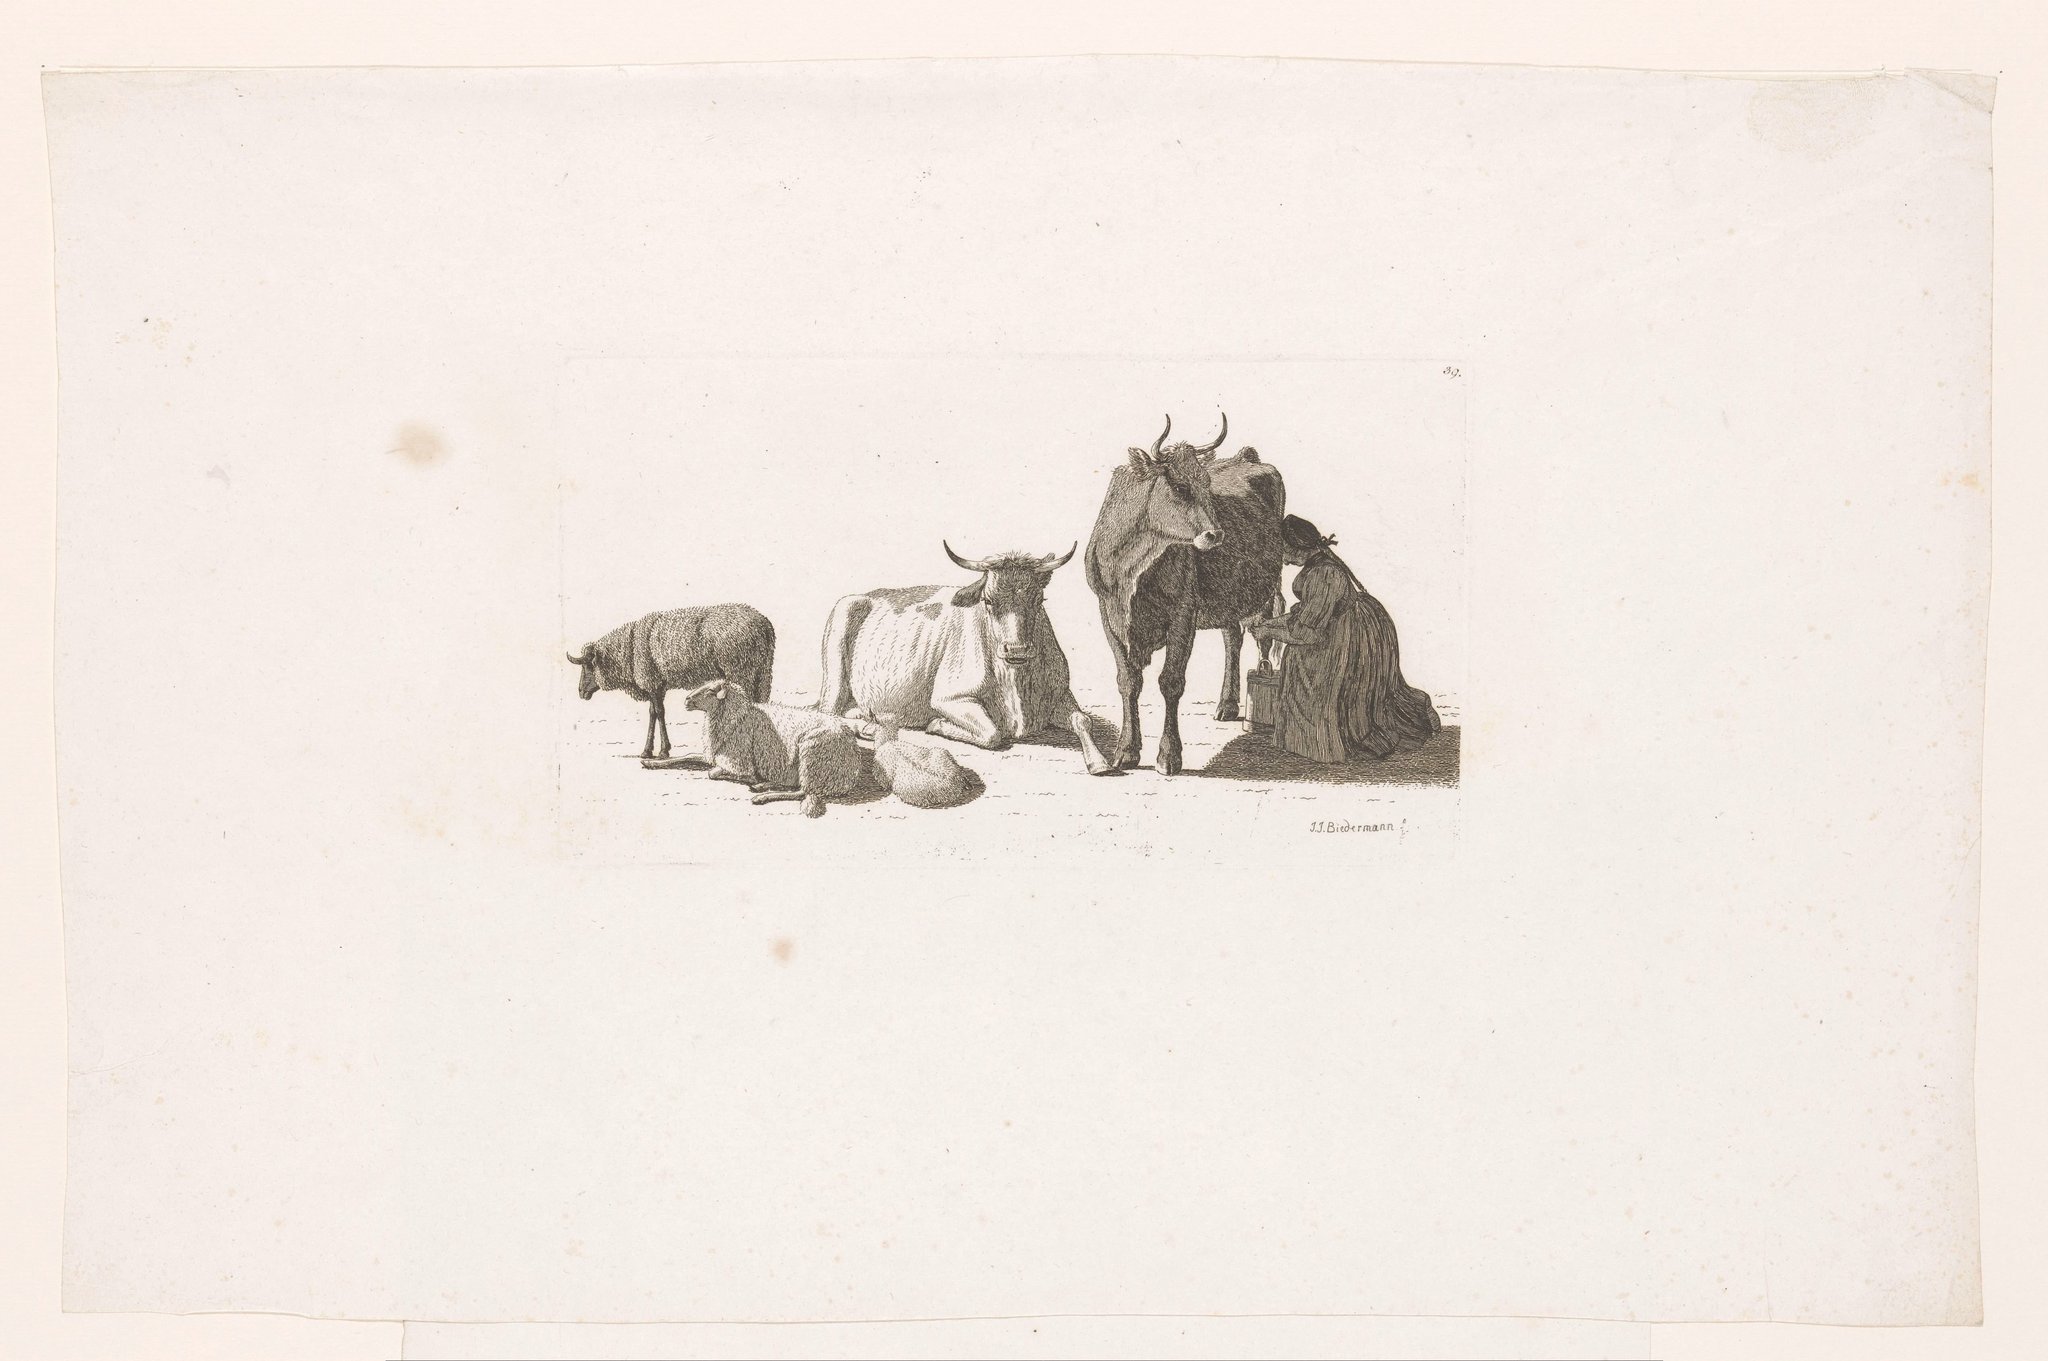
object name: print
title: Vrouw die een koe melkt, met rundvee en schapen.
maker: johan jakob biedermann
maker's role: painter, print maker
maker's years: 1763-1830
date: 1778-1830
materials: paper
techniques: etching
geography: switzerland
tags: cow, milking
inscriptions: watermark: ‘Thurneisen’, collector's mark: Lugt 2228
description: Vrouw die een koe zit te melken. Een liggend rund en drie schapen ernaast. Rechtsboven genummerd: 39.